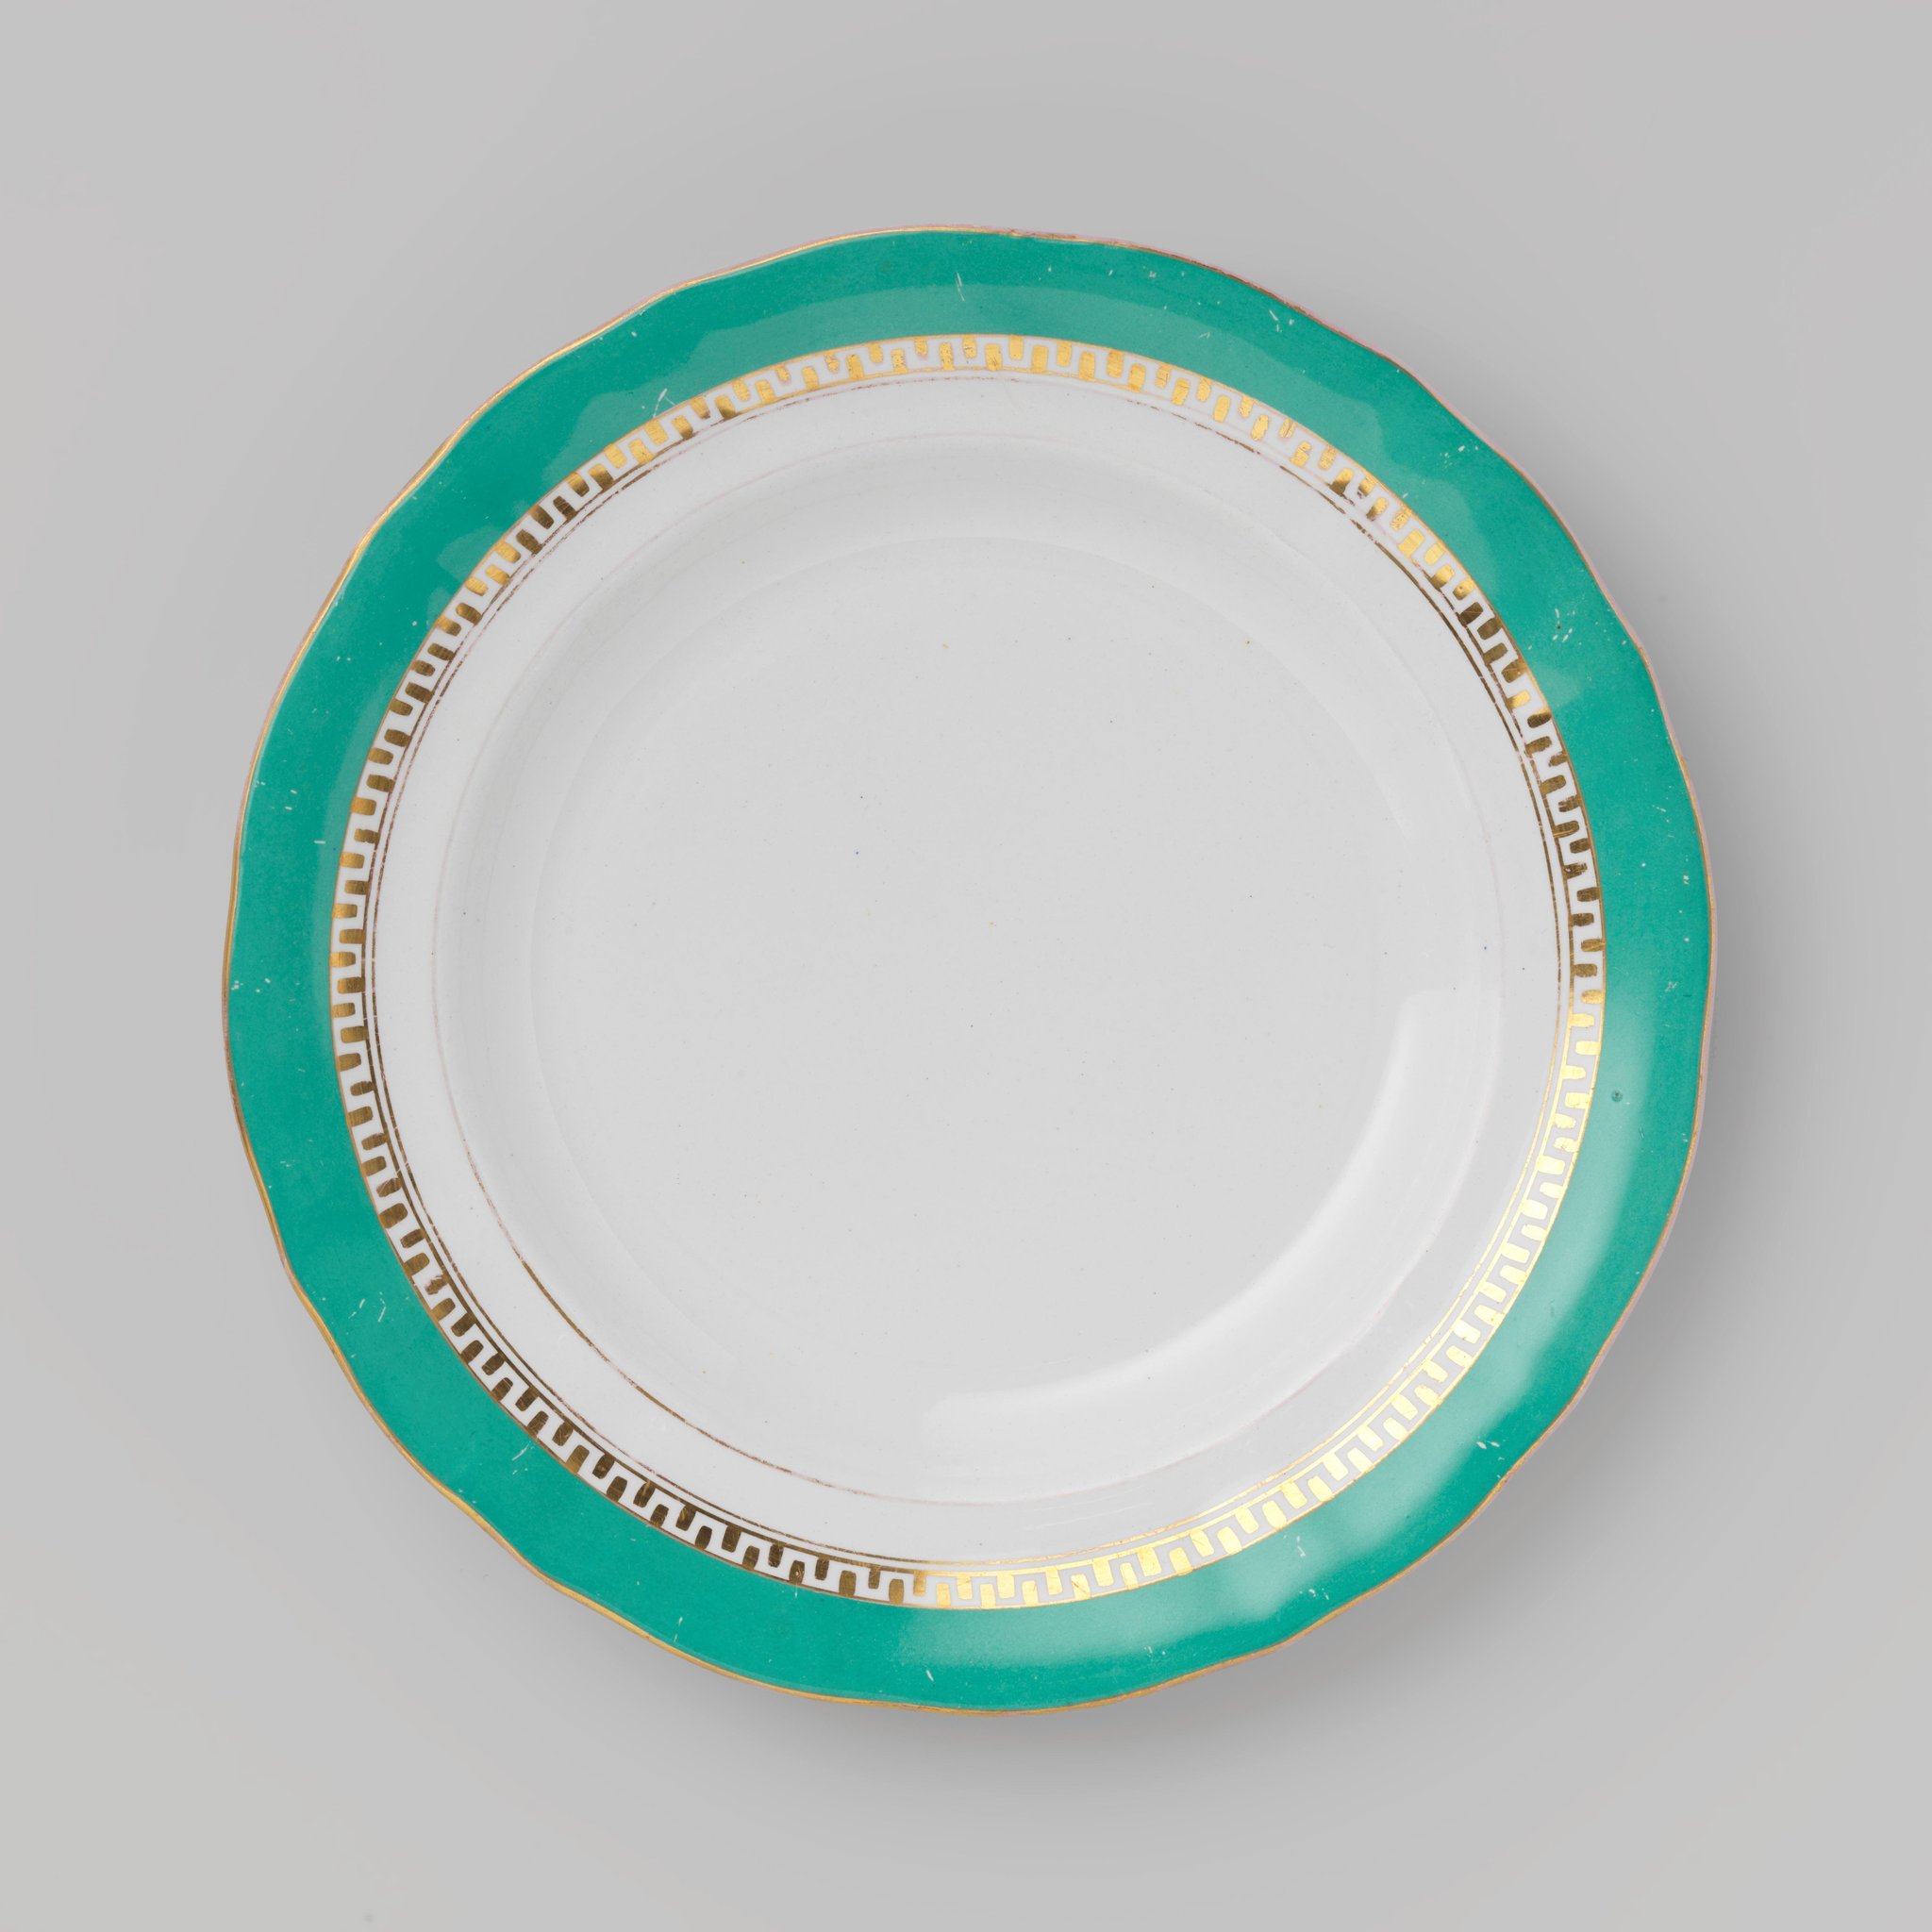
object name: plate dish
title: Bord met groene rand en gouden Griekse band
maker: petrus regout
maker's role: plateelbakker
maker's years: 1801-1879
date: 1865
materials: earthenware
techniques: transfer decoration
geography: maastricht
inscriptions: check stamp: ‘P. REGOUT // MAASTRICHT // 9X’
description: Bord van aardewerk, geschulpt, met groene rand en gouden Griekse band.